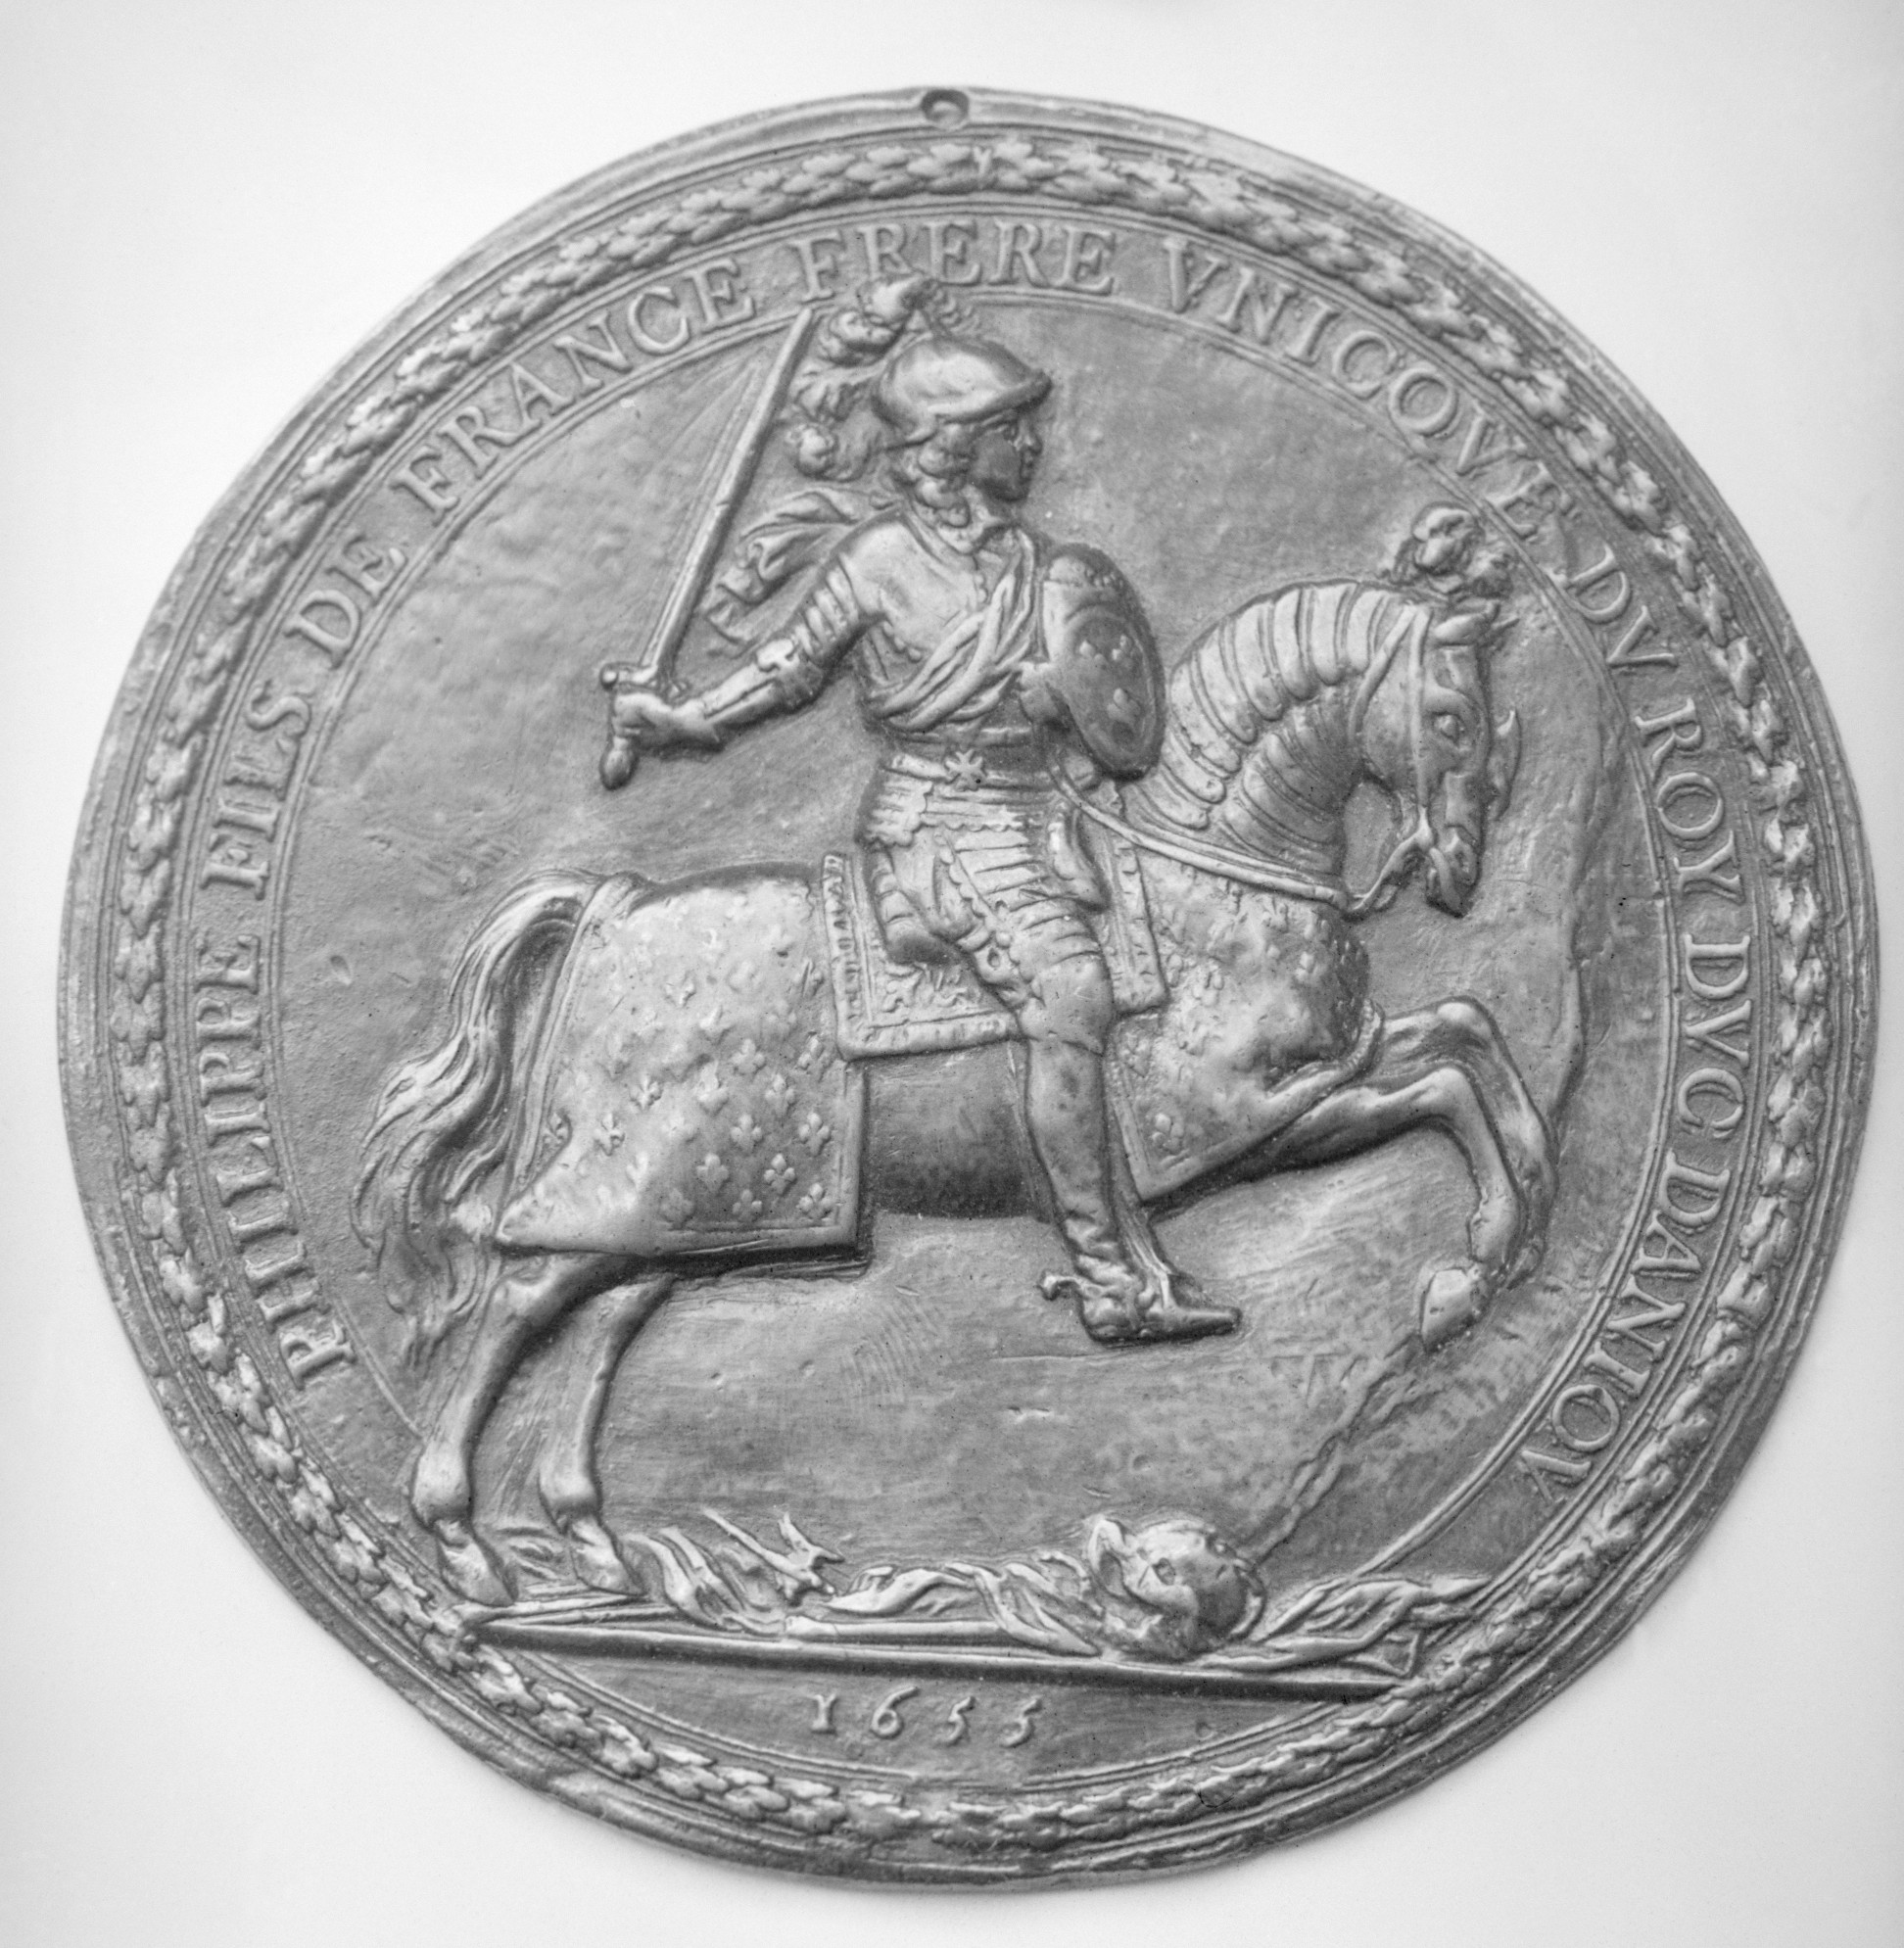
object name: medal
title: Philip of France, Duke of Anjou (1640–1701)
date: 1655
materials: bronze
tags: shields,swords,horses